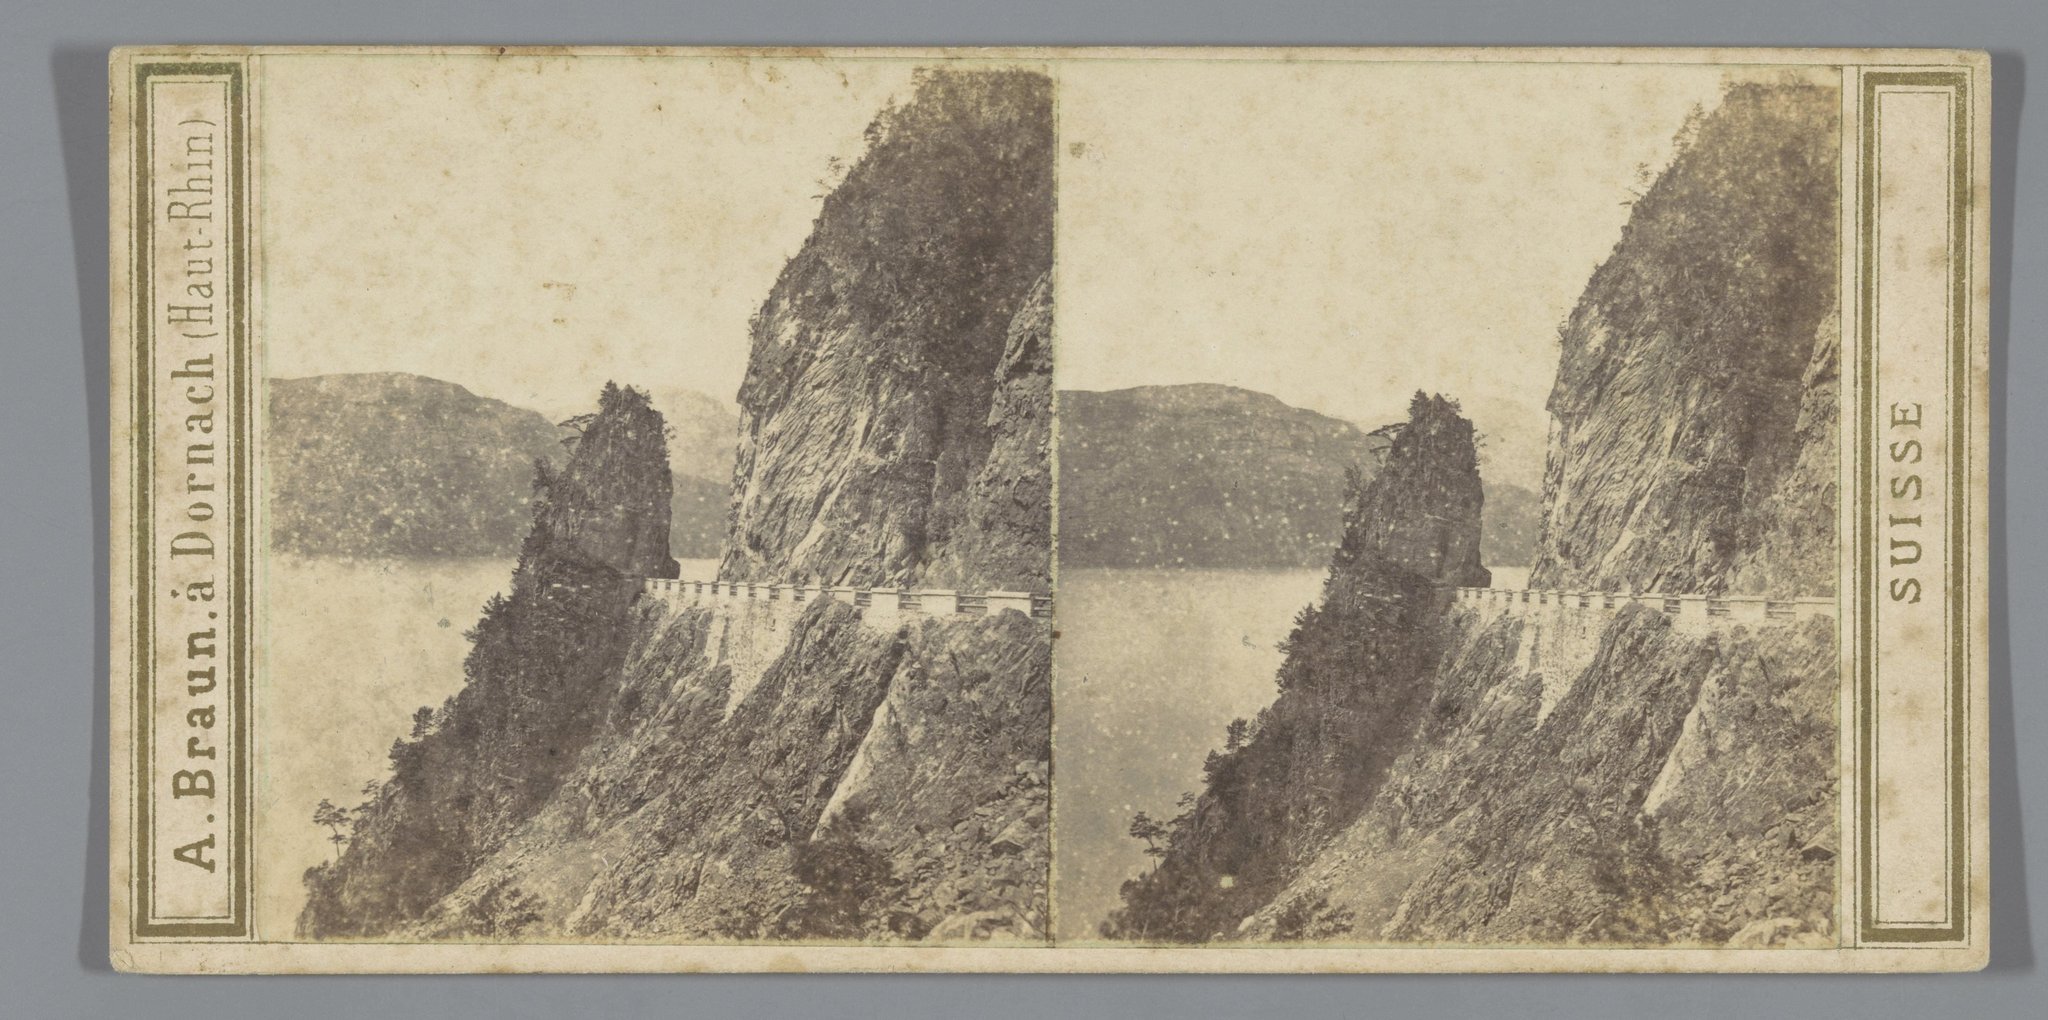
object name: stereograph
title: Lac des Quatre-Cantons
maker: Anonymous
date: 1861-1866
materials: cardboard, paper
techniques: albumen print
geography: axenstrasse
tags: lake, road, path, mountains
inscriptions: number: ‘No 5329.’